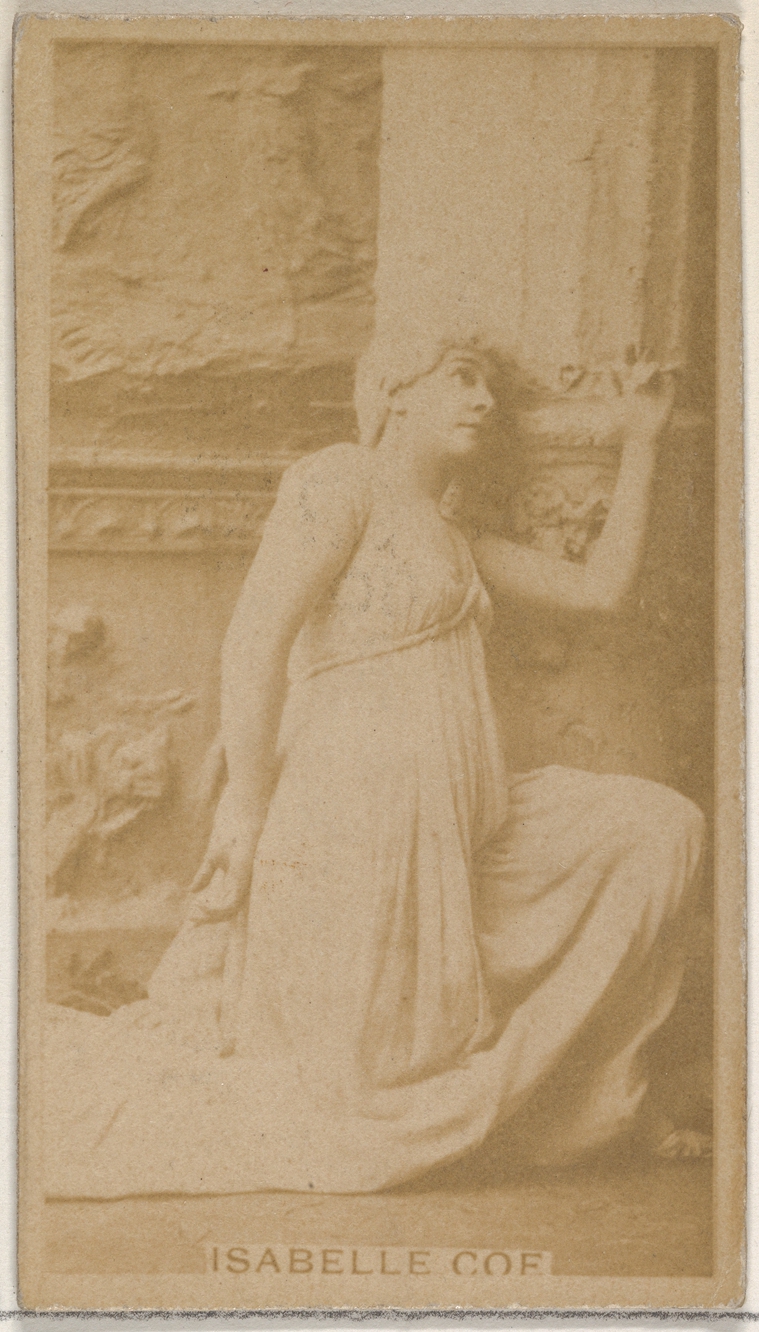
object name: photograph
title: Isabelle Coe, from the Actors and Actresses series (N45, Type 8) for Virginia Brights Cigarettes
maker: allen & ginter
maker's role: publisher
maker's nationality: american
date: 1888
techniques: albumen silver print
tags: portraits,women,actresses